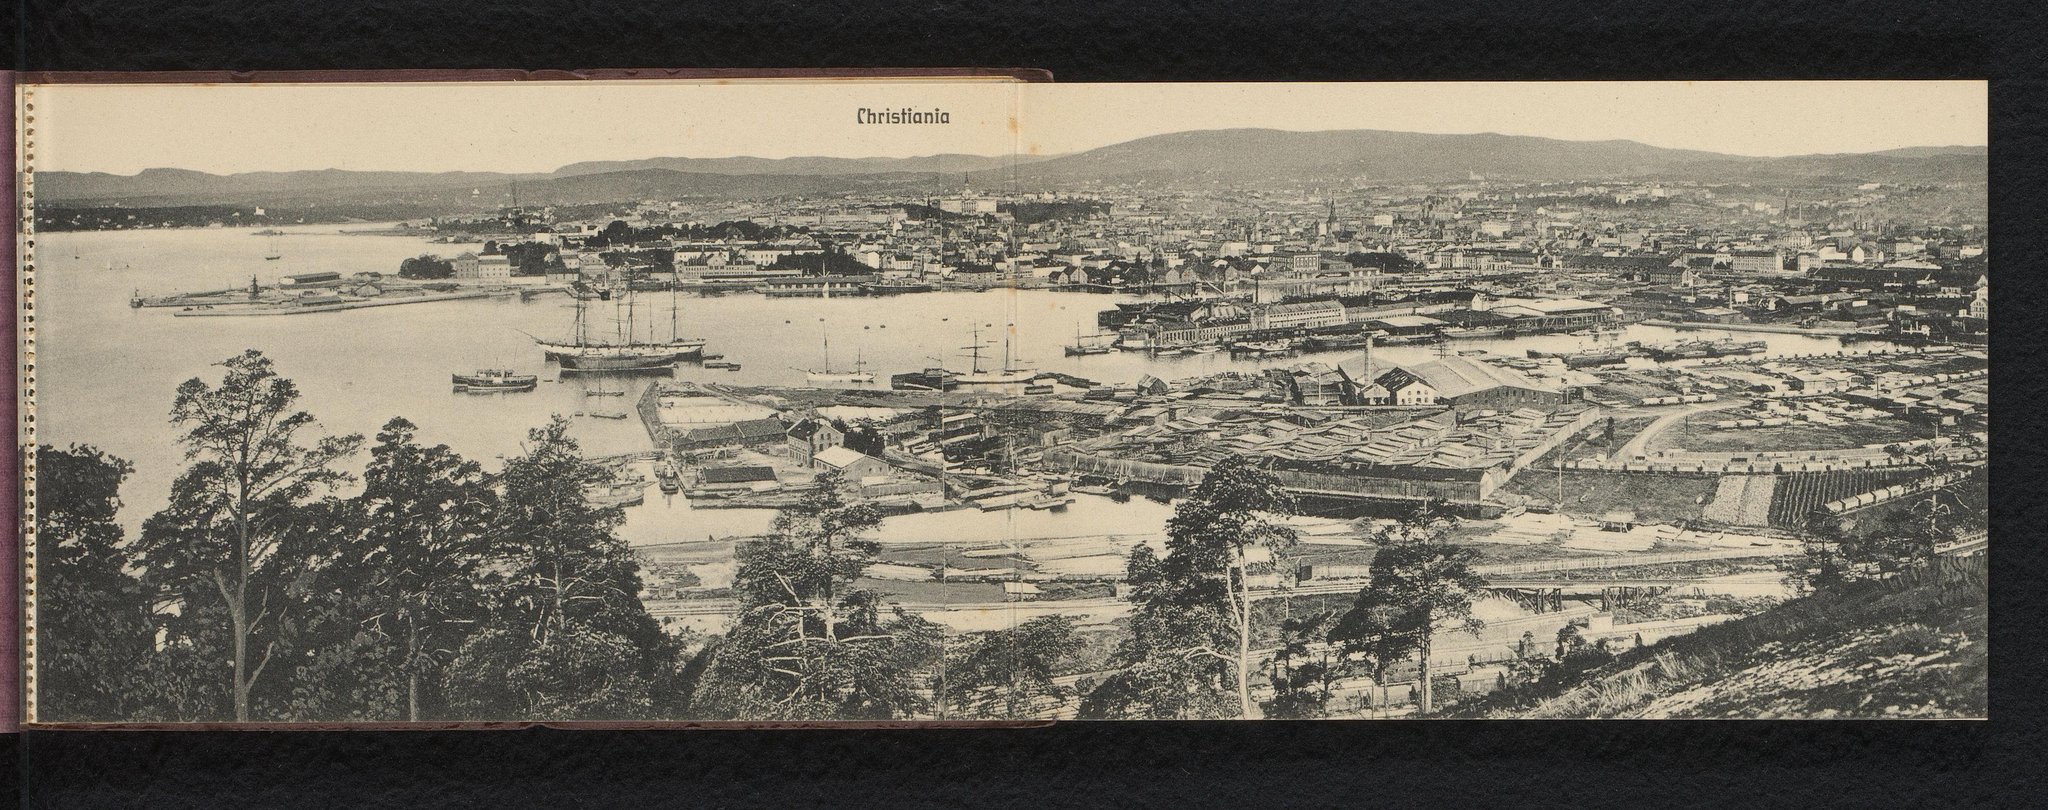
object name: photomechanical print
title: Christiania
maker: Anonymous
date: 1904-1925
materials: cardboard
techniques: photograph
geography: oslo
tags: harbour, prospect of city, town panorama, silhouette of city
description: Prentbriefkaart maakt deel uit van een album.